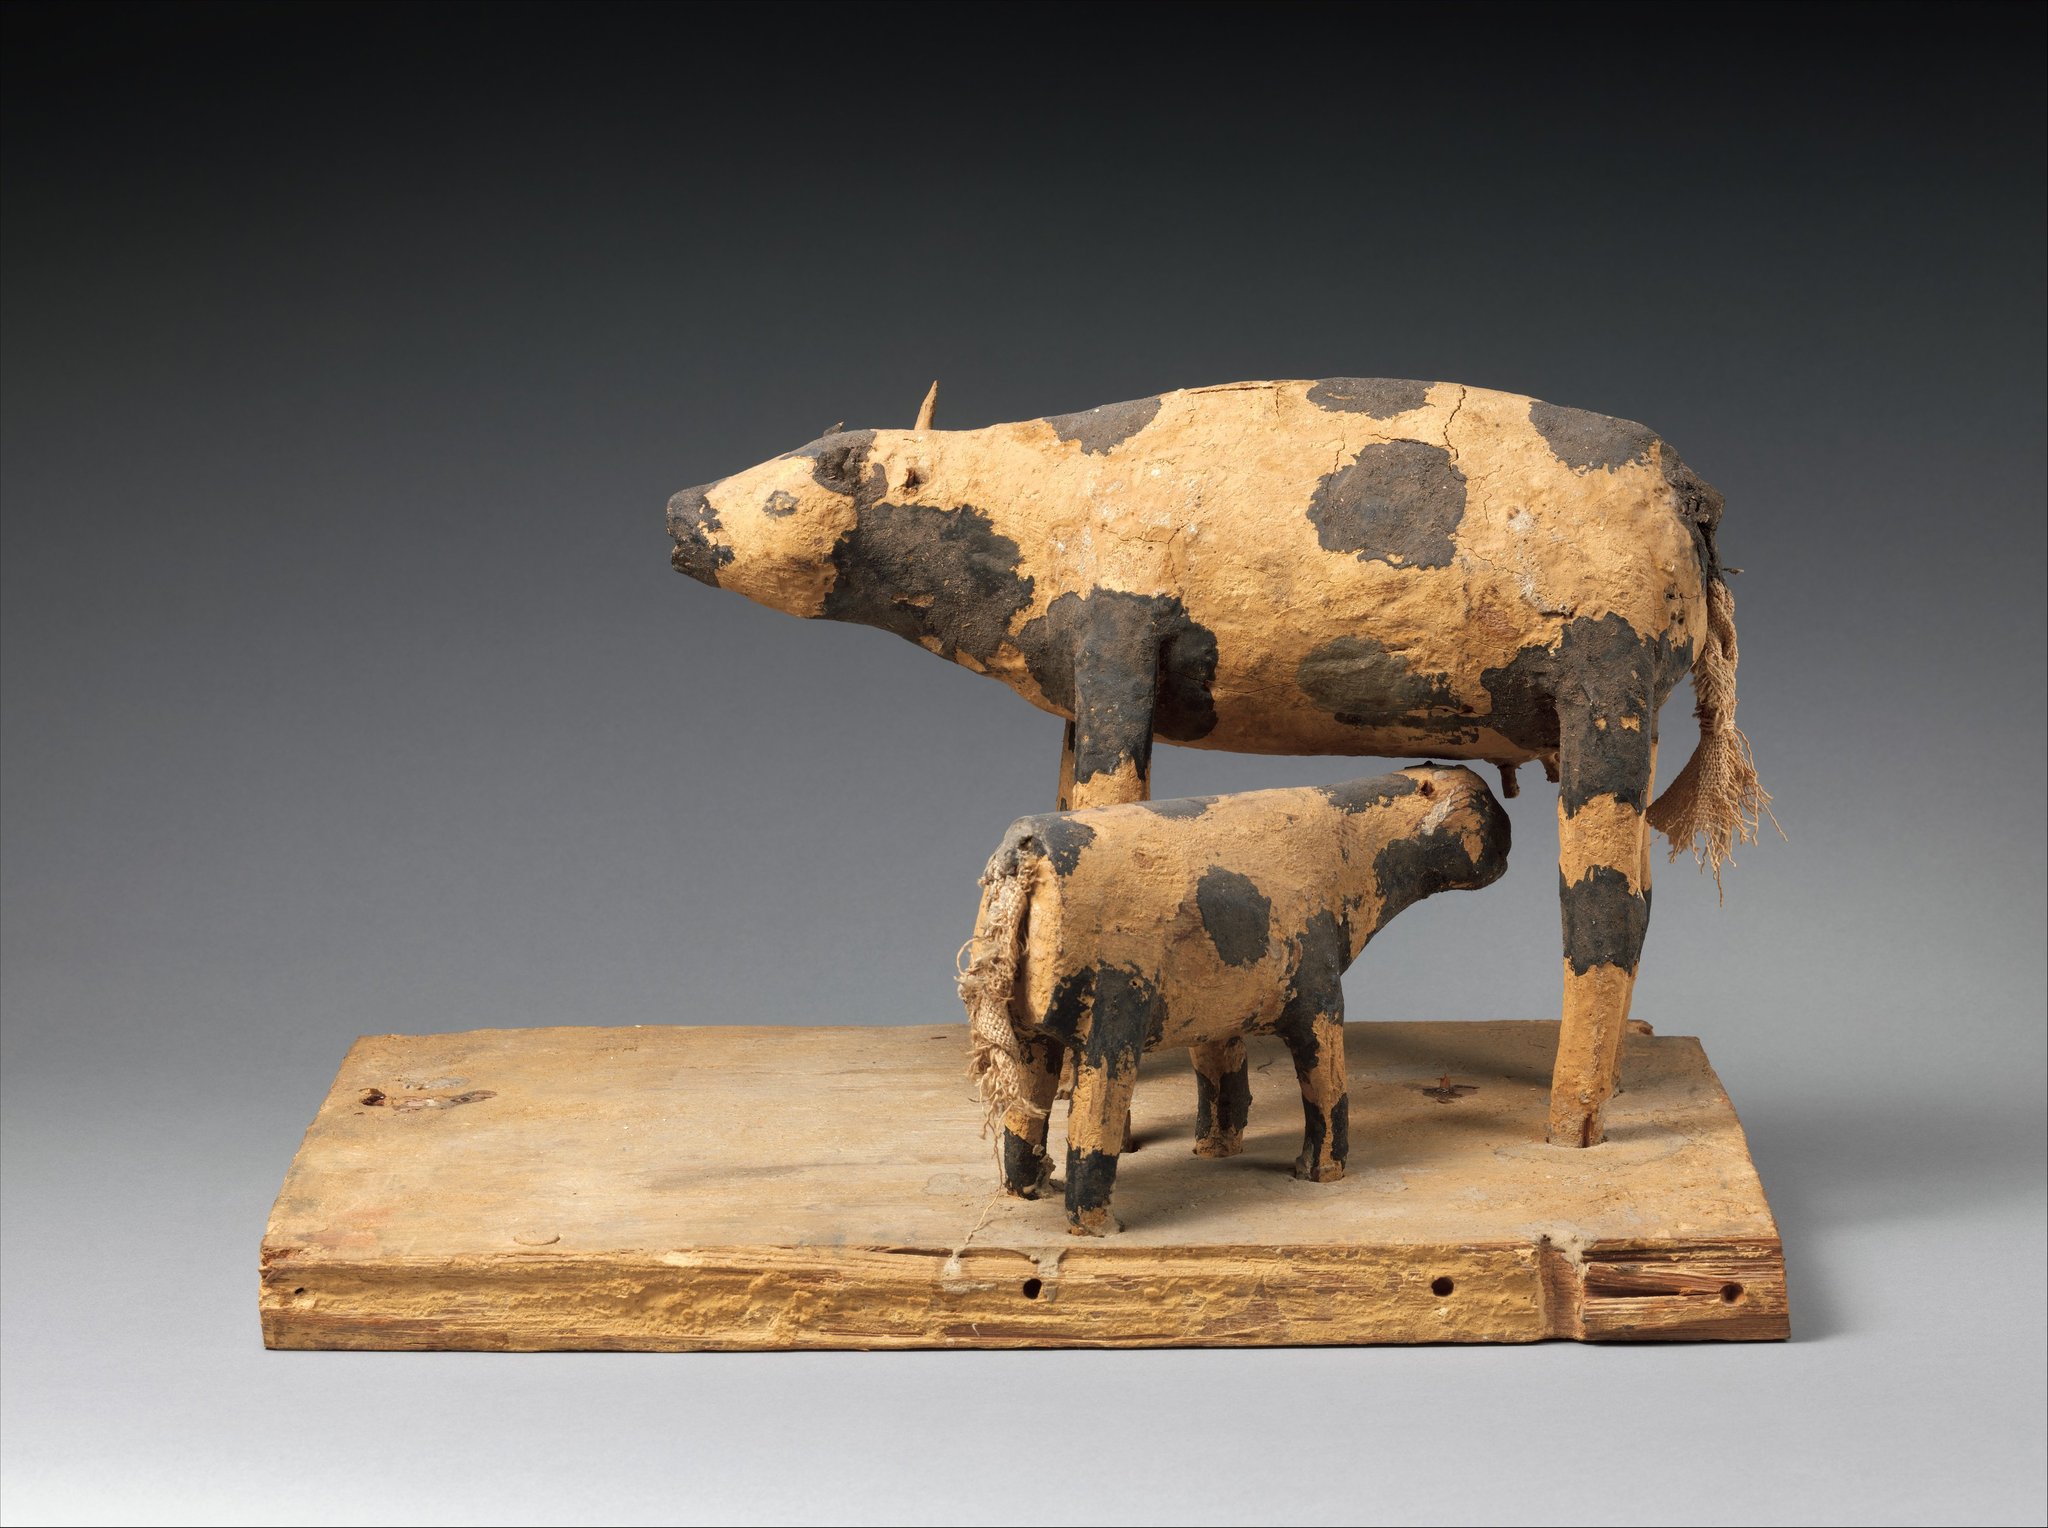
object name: model, cow, nursing, calf, cattle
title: Model of a Cow and Her Calf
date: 2030-1850 BCE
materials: wood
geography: egypt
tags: cows